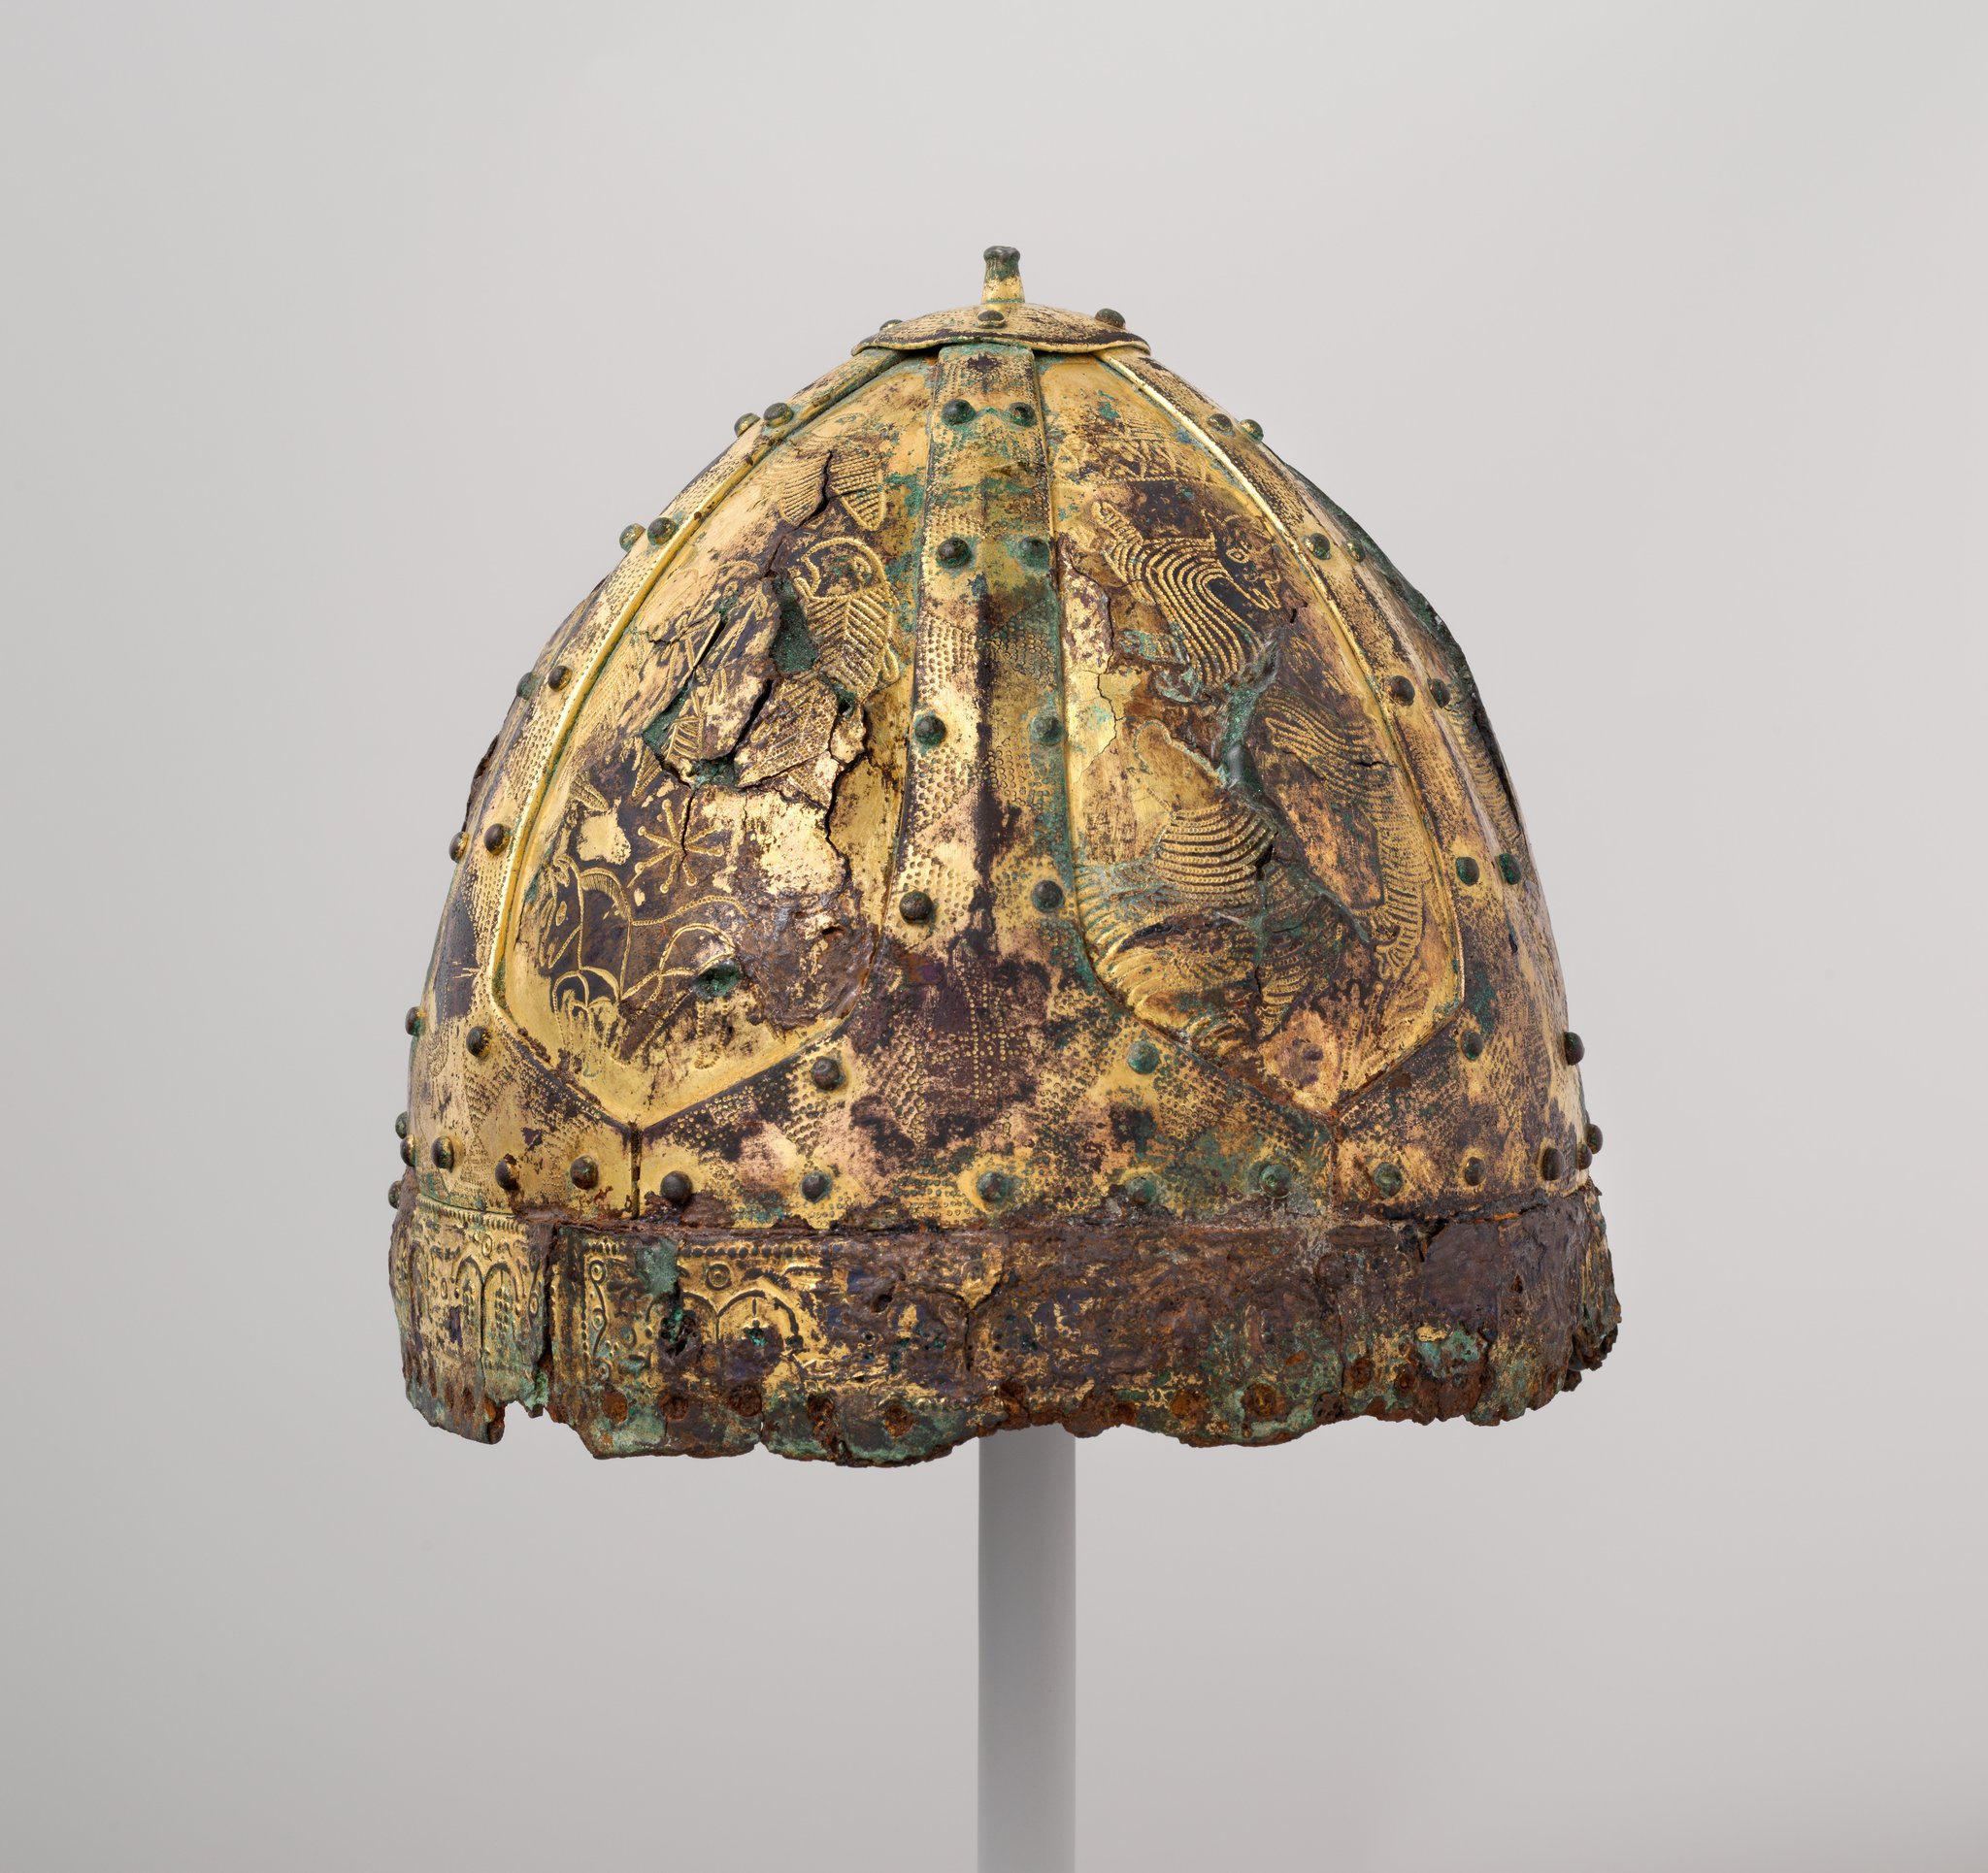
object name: helmet i spangenhelm i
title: Helmet (Spangenhelm)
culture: byzantine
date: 501-600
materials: copper alloy, gold, iron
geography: europe